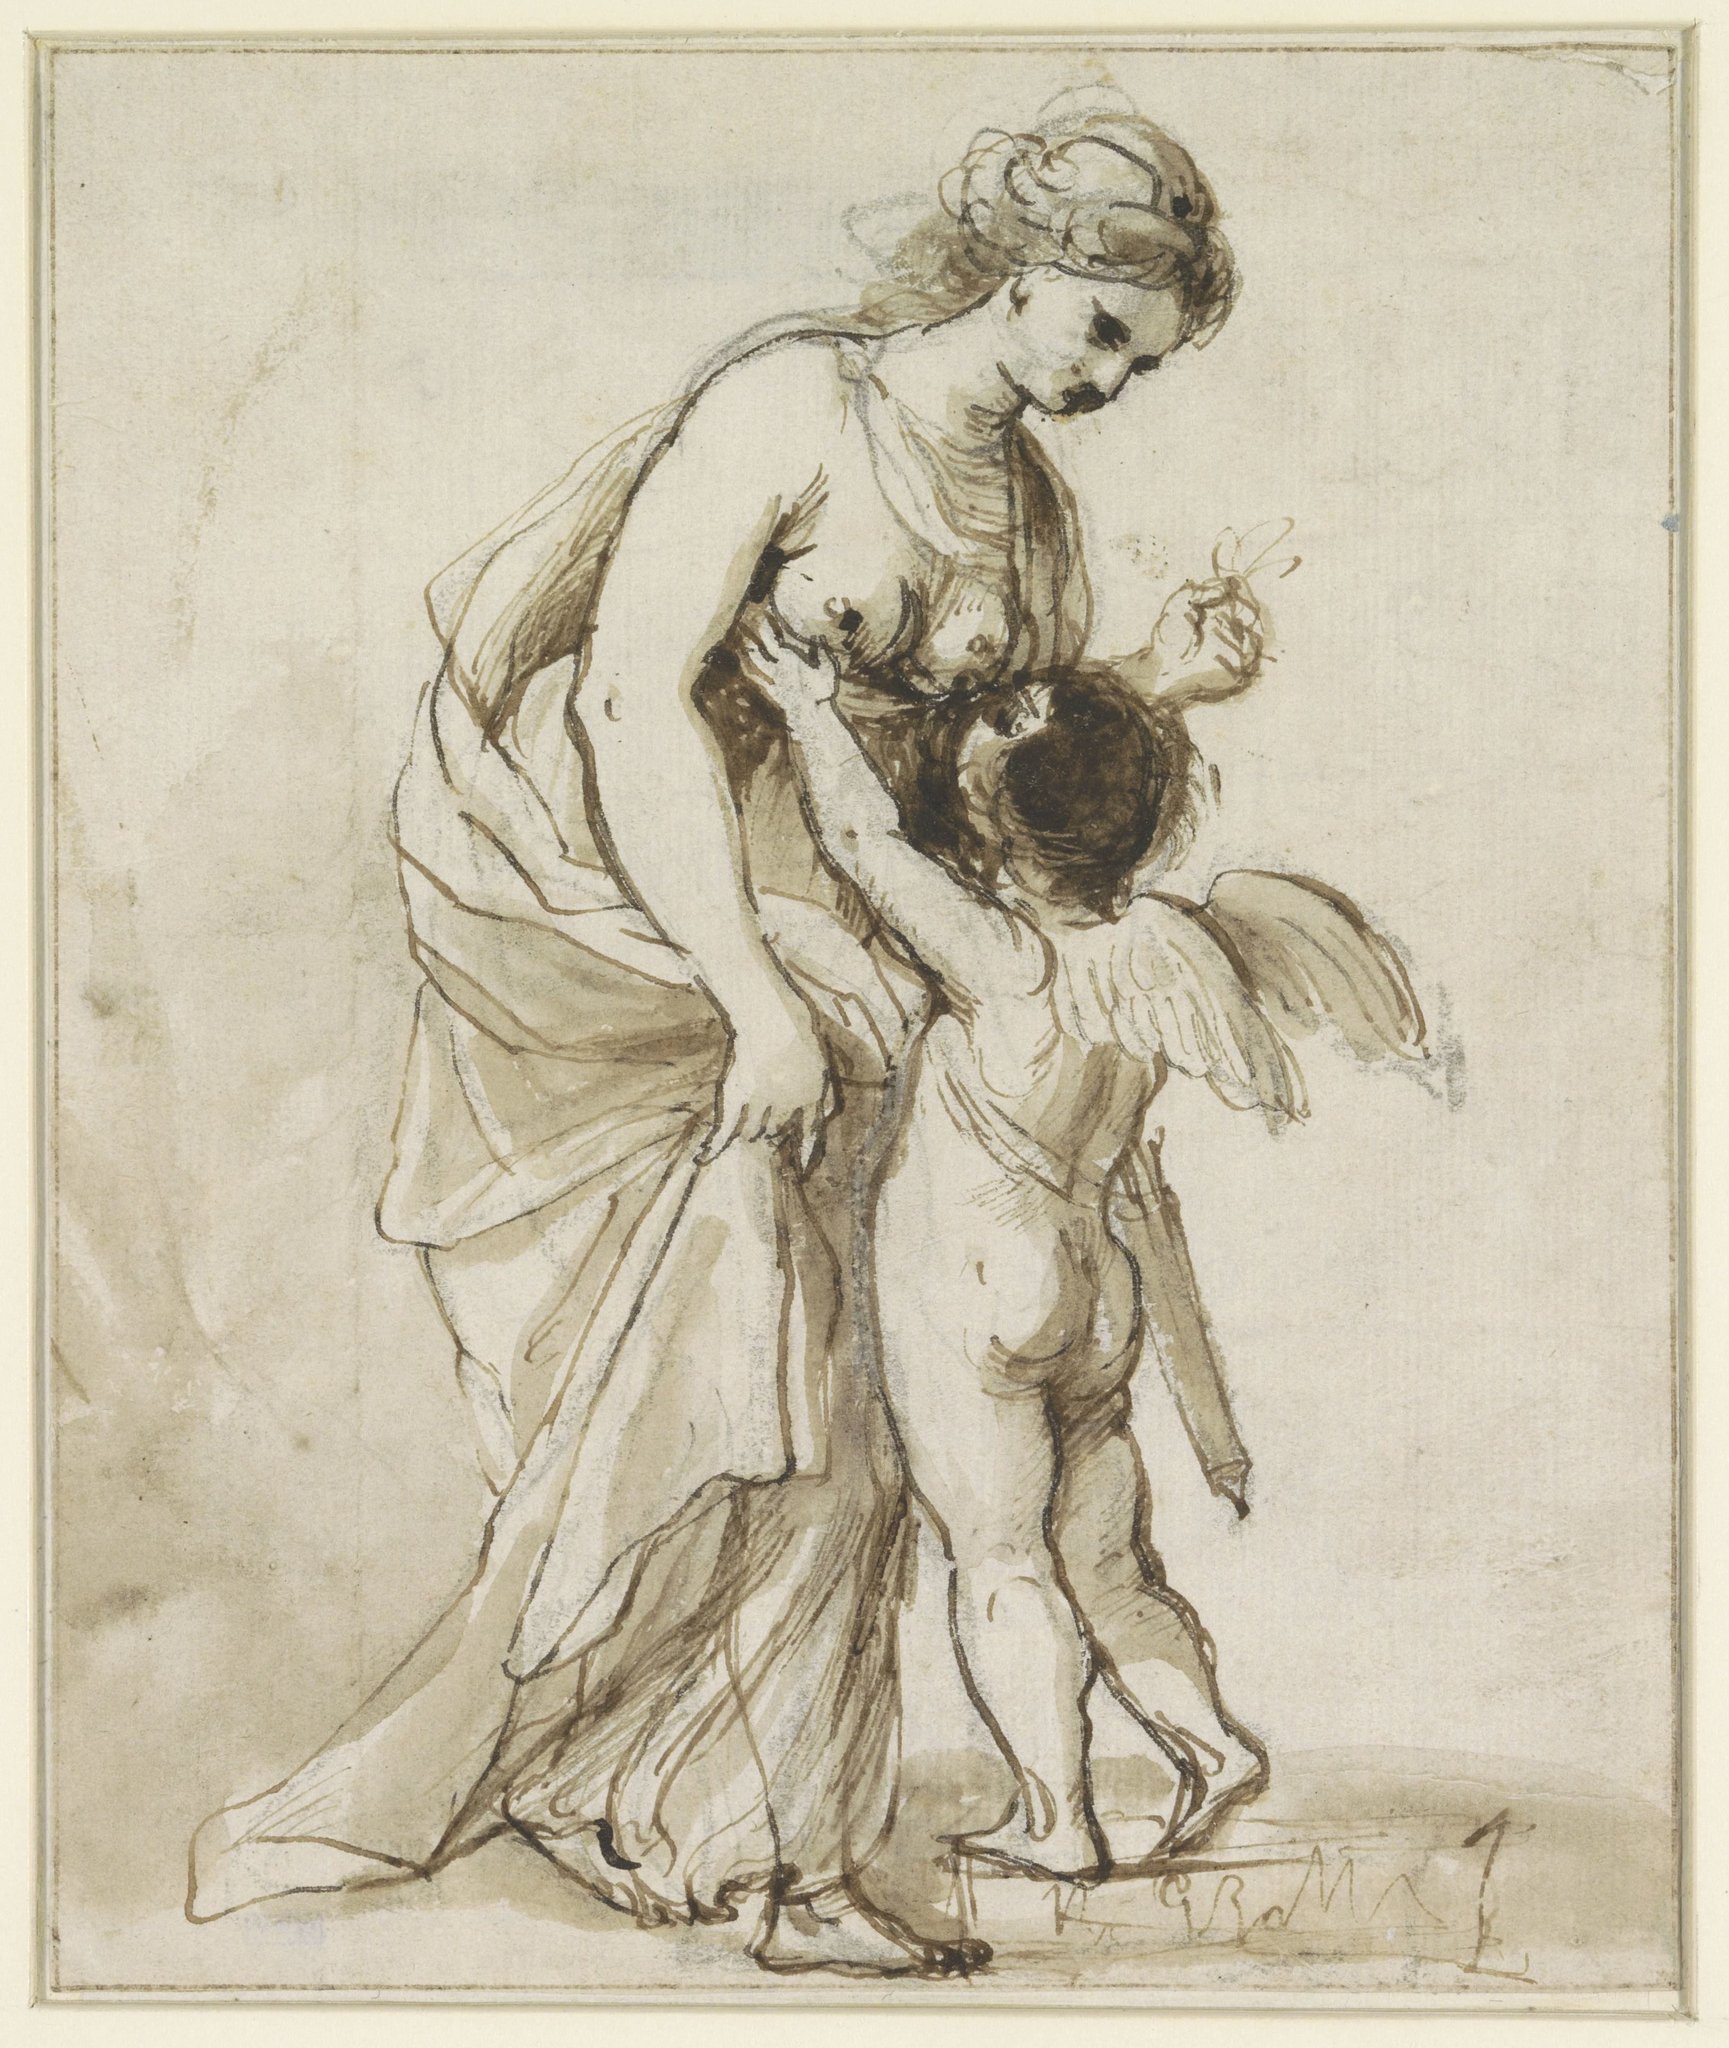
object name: drawing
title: Venus en Amor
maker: angelica kauffmann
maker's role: draughtsman, print maker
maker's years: 1741-1807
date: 1751-1807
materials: chalk, ink, paper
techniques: brush, pen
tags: (story of) cupid, amor (eros), (story of) venus (aphrodite)